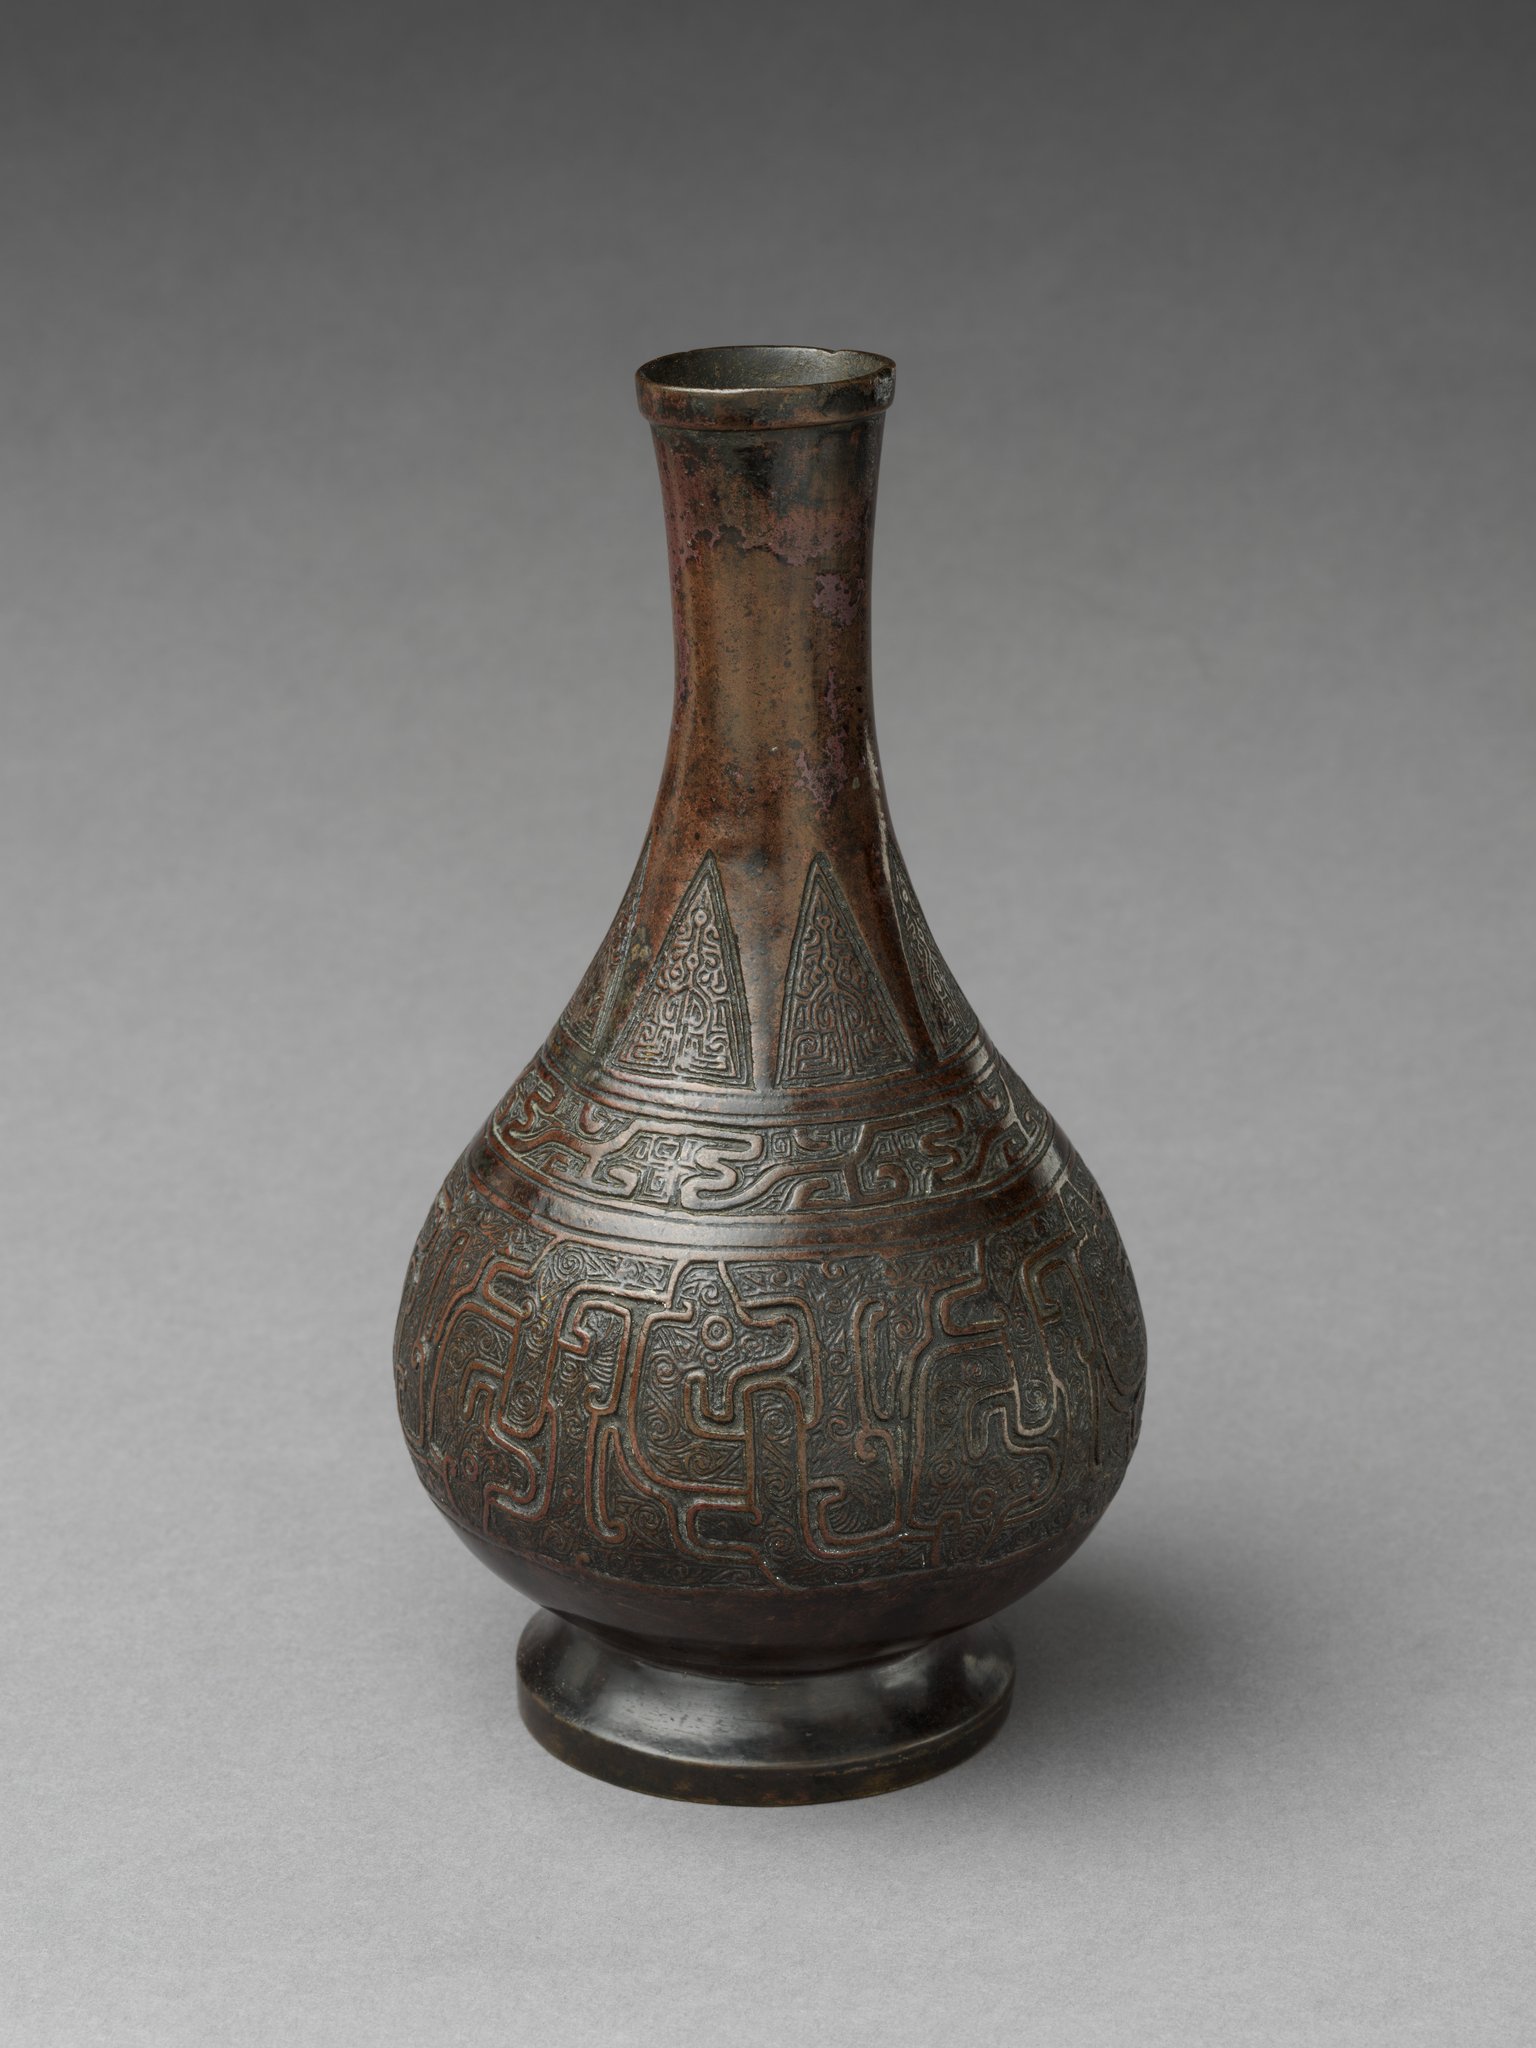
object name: vase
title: Vase with archaic-style patterns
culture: chinese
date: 1201-1300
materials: copper alloy